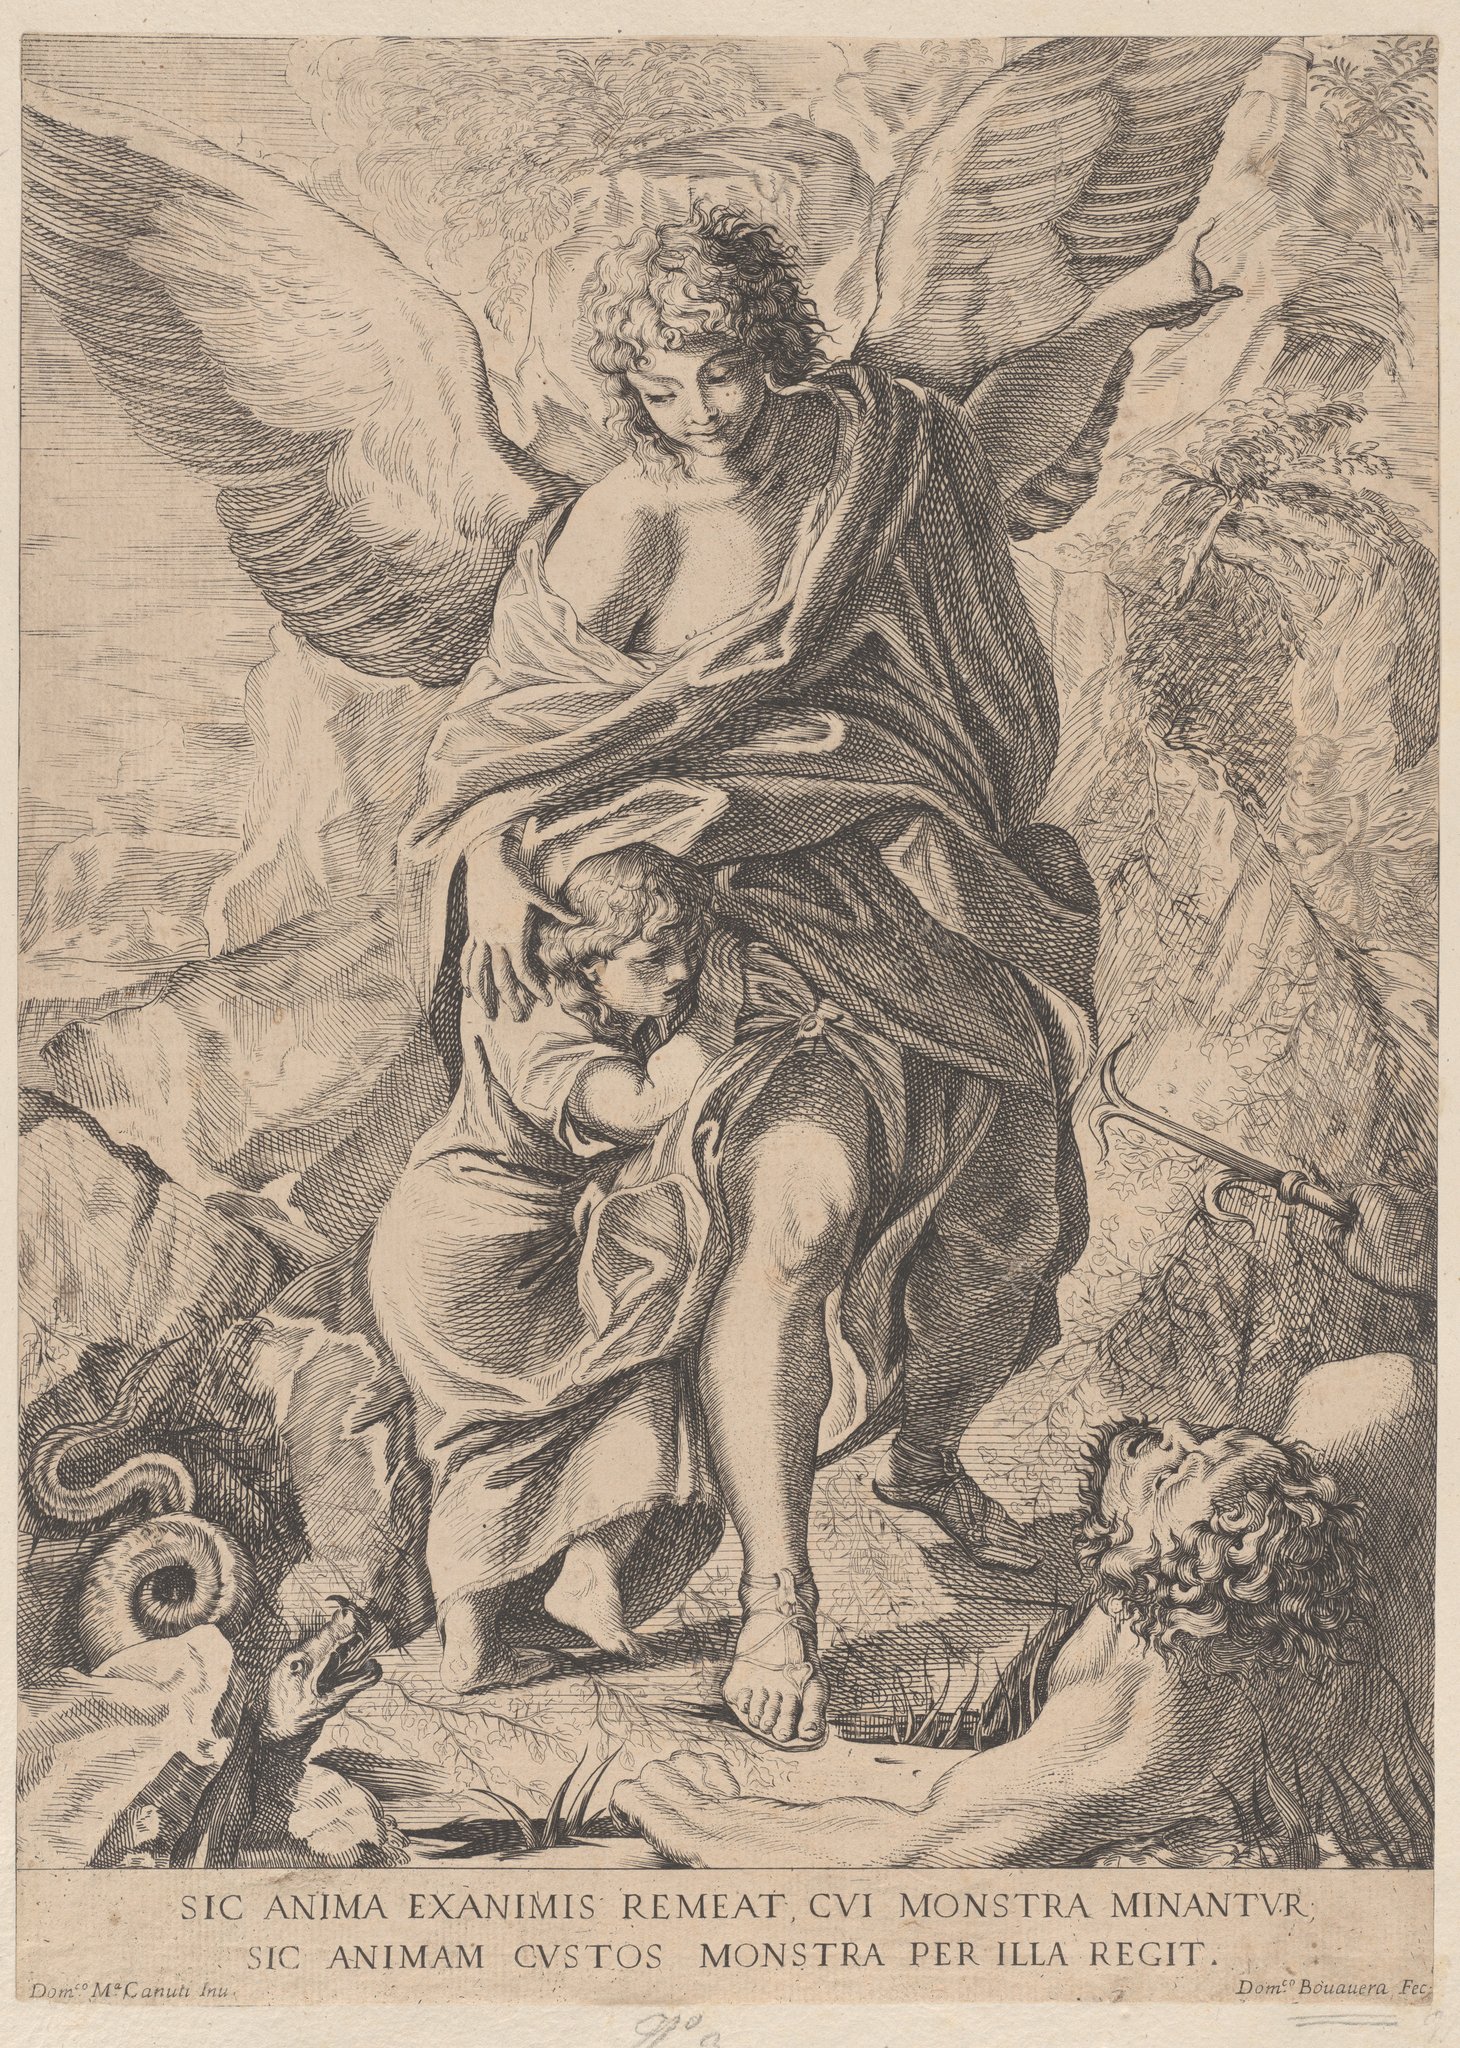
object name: print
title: Guardian angel leading a child through danger, with a snake at lower left and a demon at lower right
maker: domenico maria bonavera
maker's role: artist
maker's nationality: italian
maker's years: 1653-1731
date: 1670-1731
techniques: etching